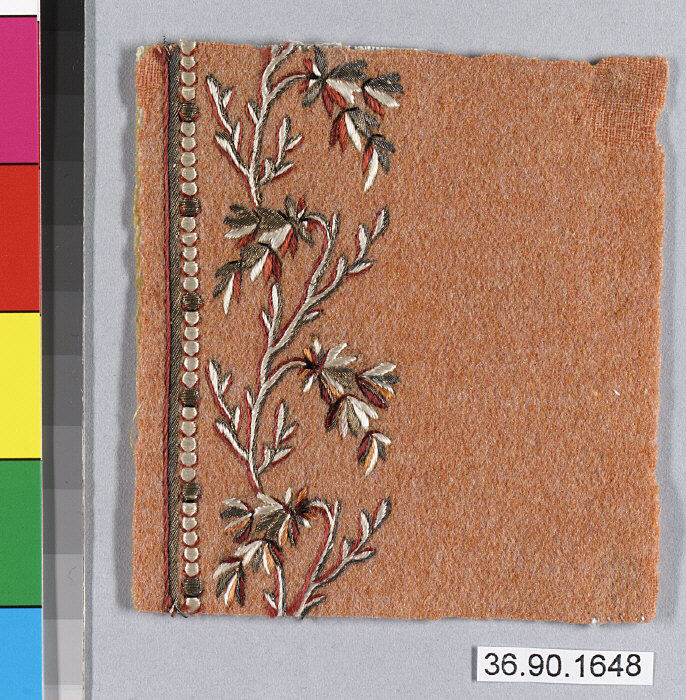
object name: sample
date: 1801-1833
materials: felt, metal thread, silk